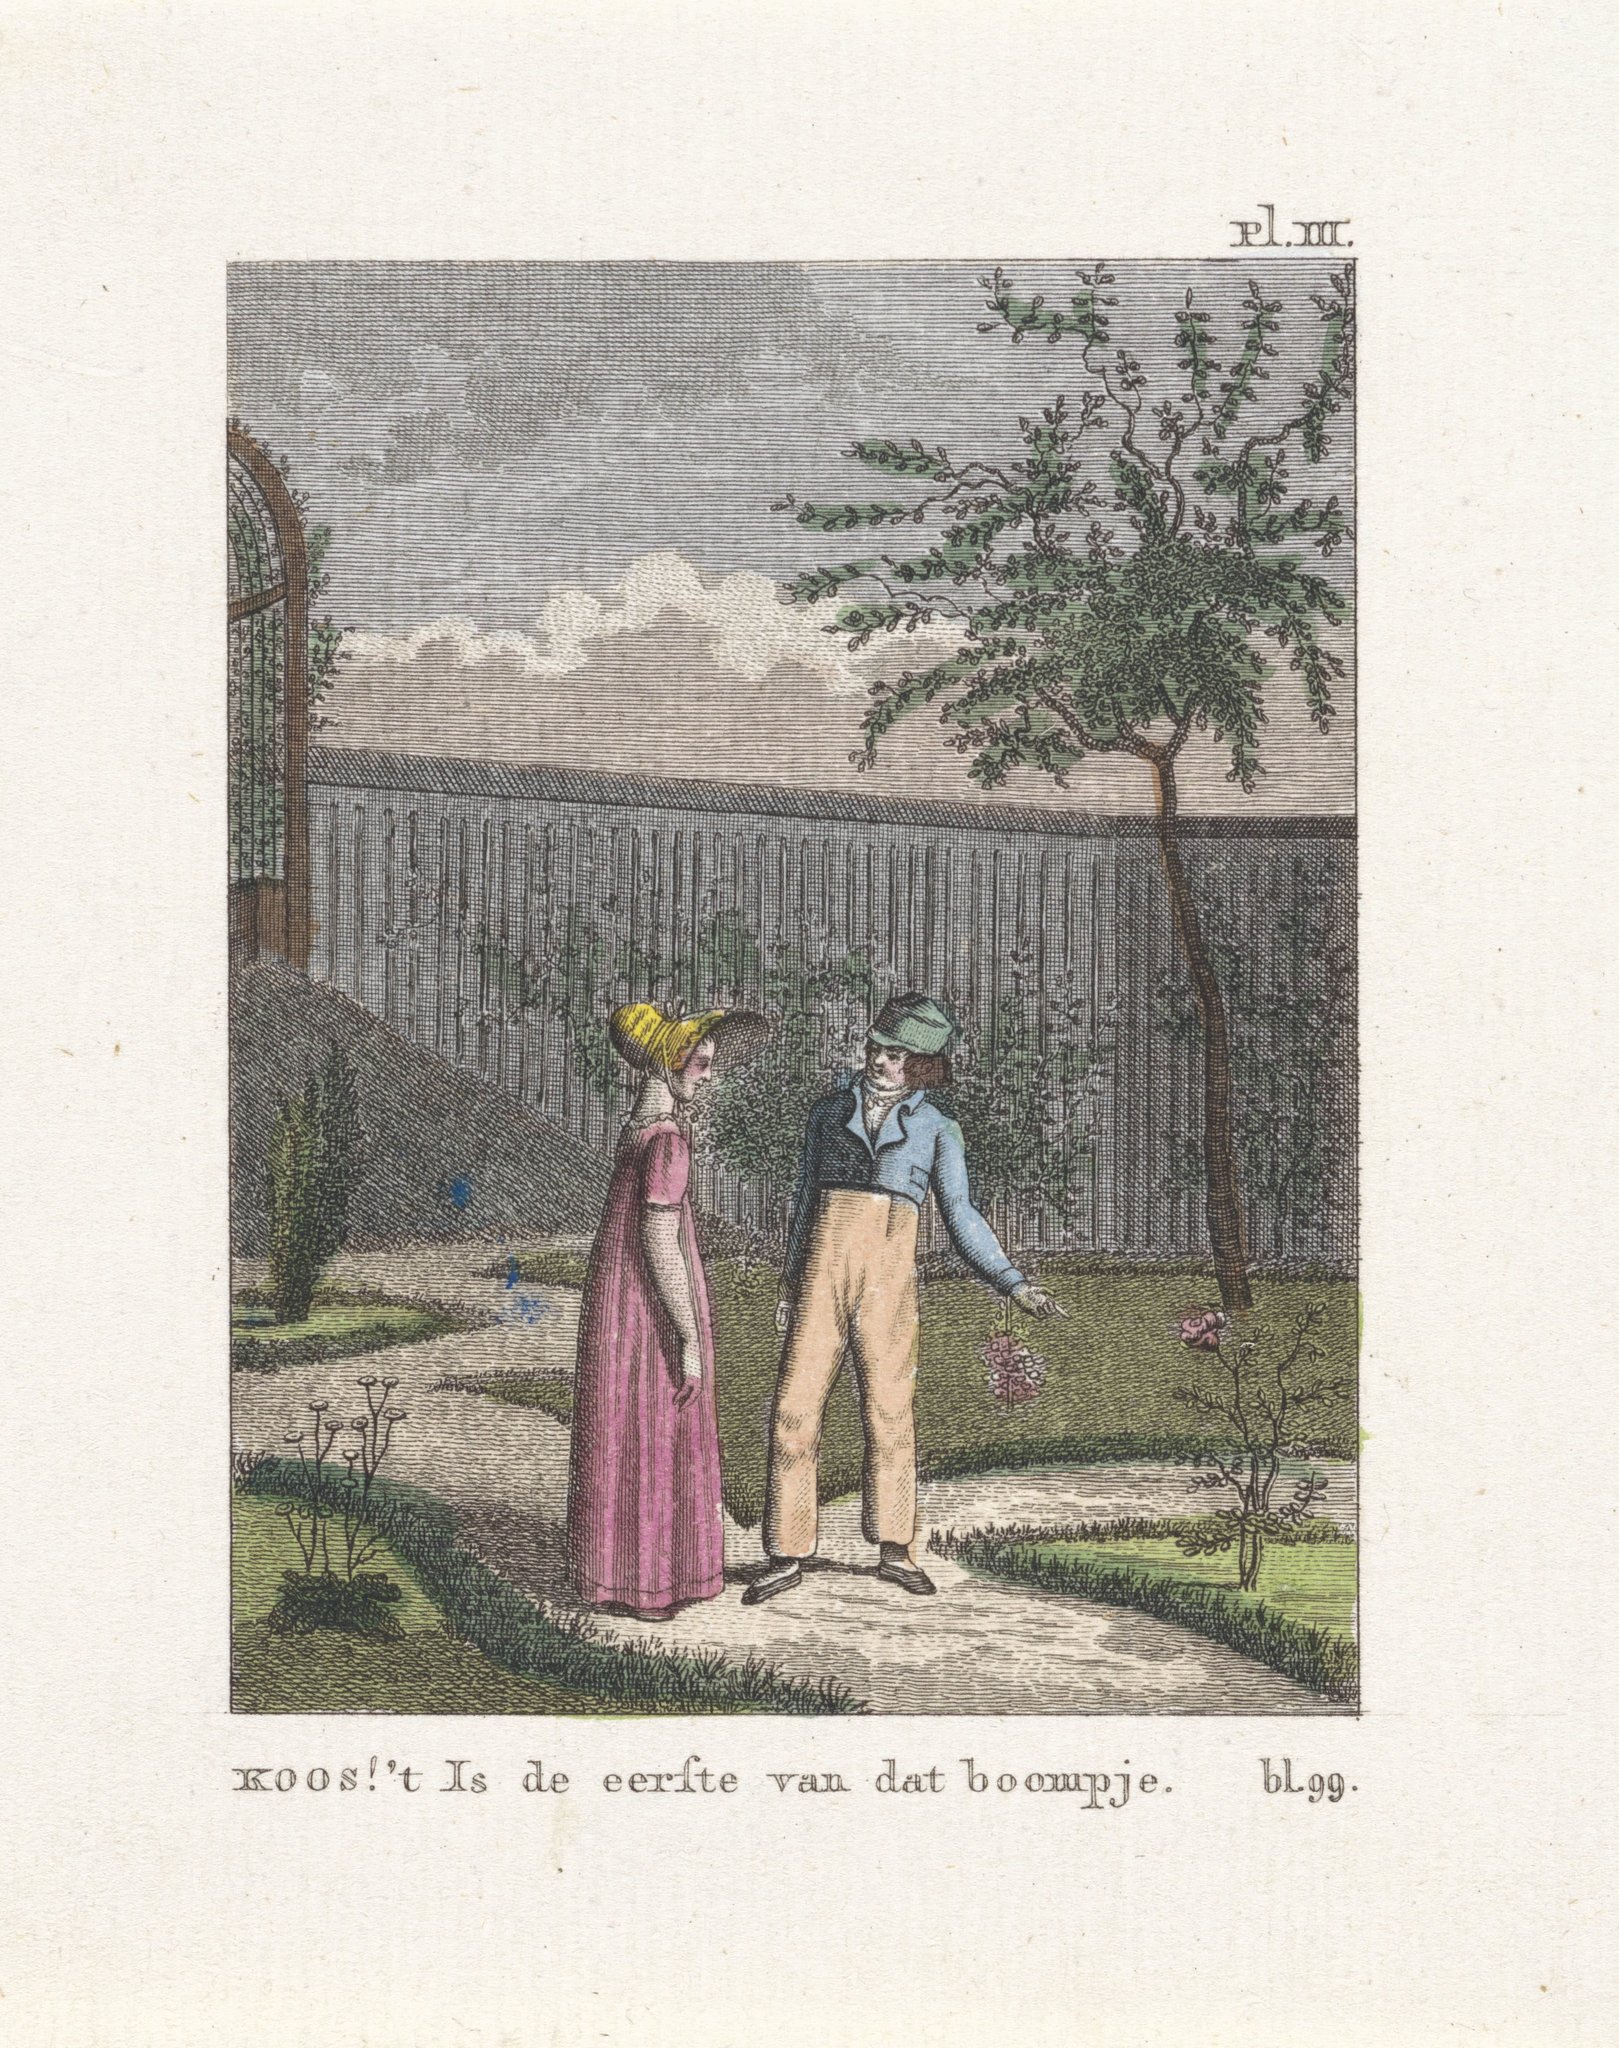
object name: book illustration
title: Koos! 't Is de eerste van dat boompje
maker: izaak jansz. de wit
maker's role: draughtsman, print maker, publisher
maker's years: 1744-1809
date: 1806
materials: paper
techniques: etching, hand coloring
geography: haarlem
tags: garden, fence, wall, paling, flowers: rose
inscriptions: collector's mark: Lugt 2228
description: Prent gebruikt in: Moens, Petronella. Letter-kransje voor lieve en brave kinderen. Haarlem: Adriaan Pietrsz. Loosjes, 1806.